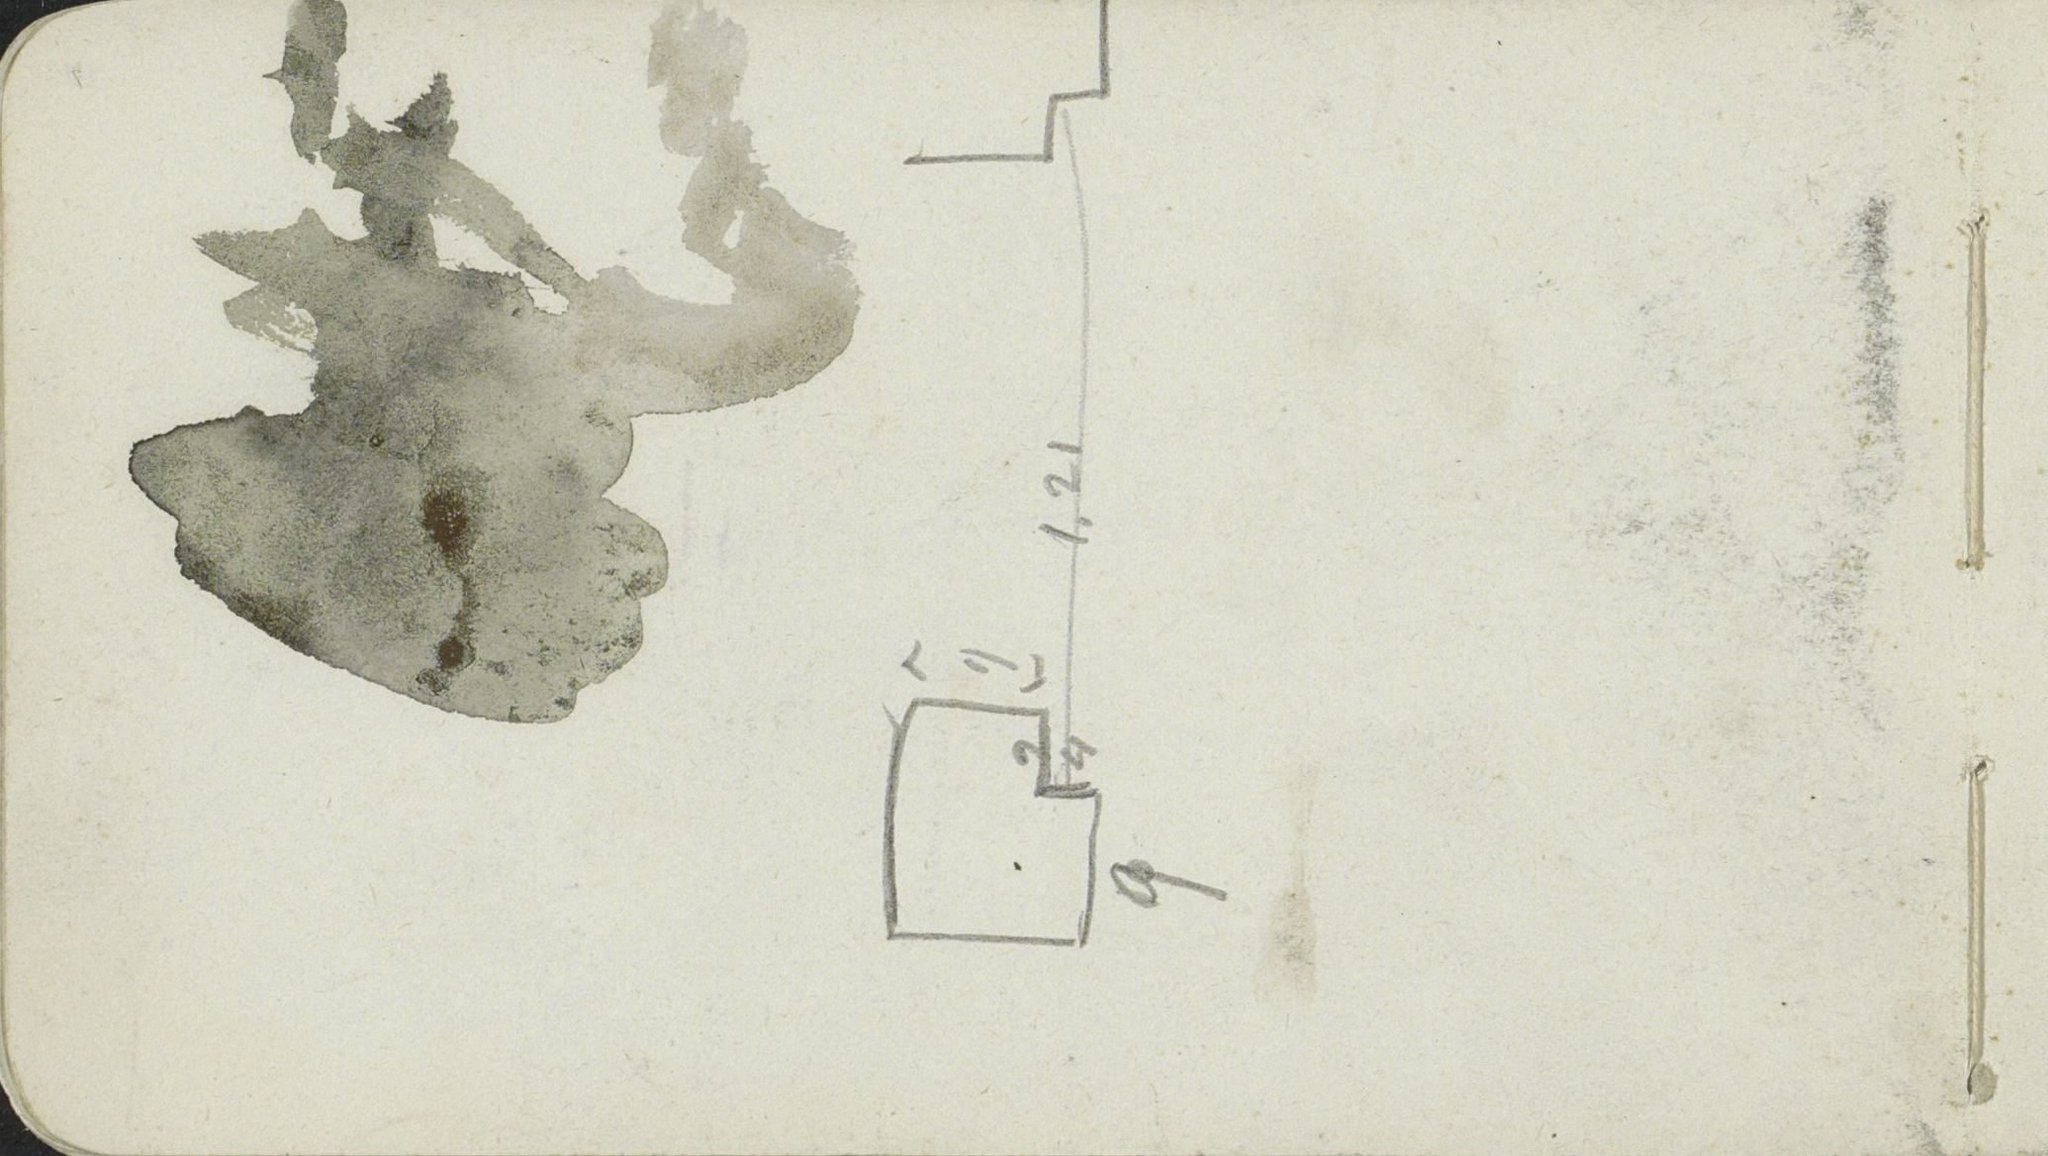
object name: sketchbook leaf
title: Plattegrond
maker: carel adolph lion cachet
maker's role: draughtsman, print maker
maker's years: 1864-1945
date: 1905-1906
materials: paper, pencil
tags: plan ~ architecture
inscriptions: annotation: ‘[...]’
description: Blad 4 verso uit een schetsboek met 34 bladen.